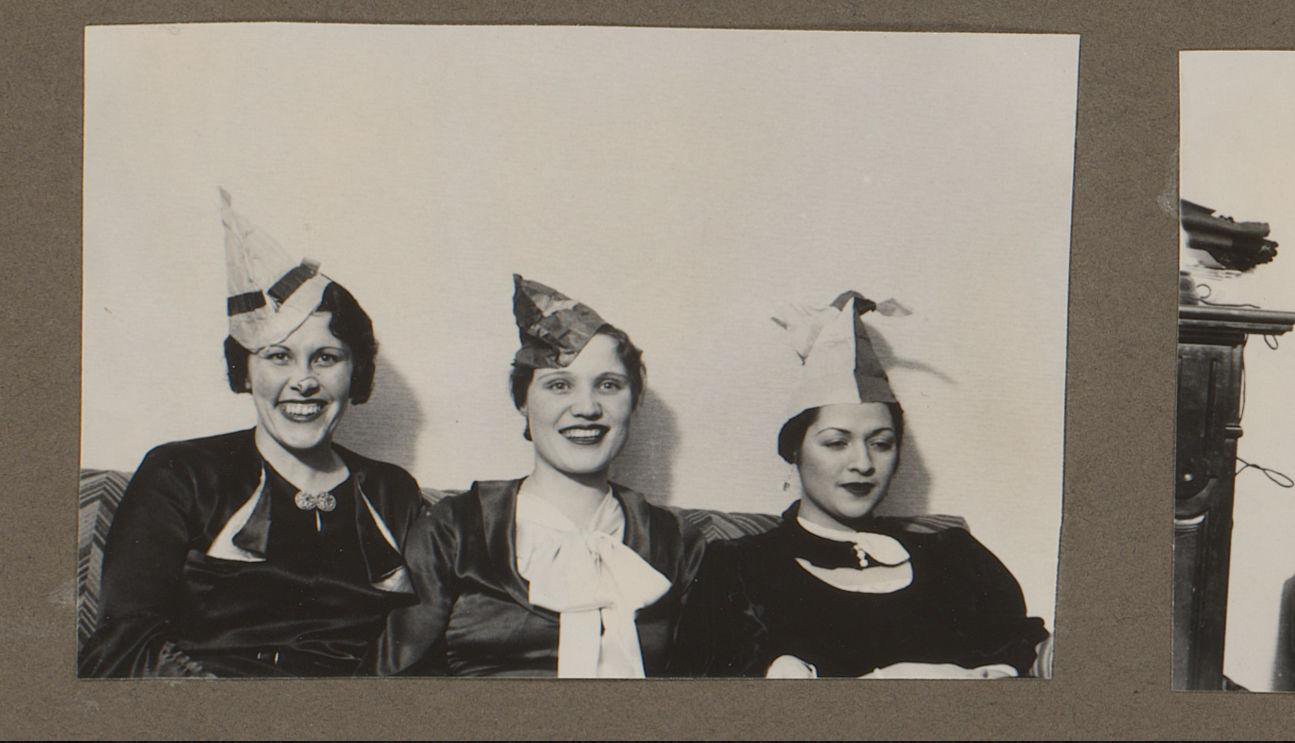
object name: album leaf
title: Groepsportret van Wilhelmina van Zijll de Jong en twee andere vrouwen met feesthoeden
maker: Anonymous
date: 1934-1935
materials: paper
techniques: gelatin silver print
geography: netherlands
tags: the hague, wilhelmina van zijll de jong, party clothes, festive attire, historical persons not known by name - bb - woman, netherlands